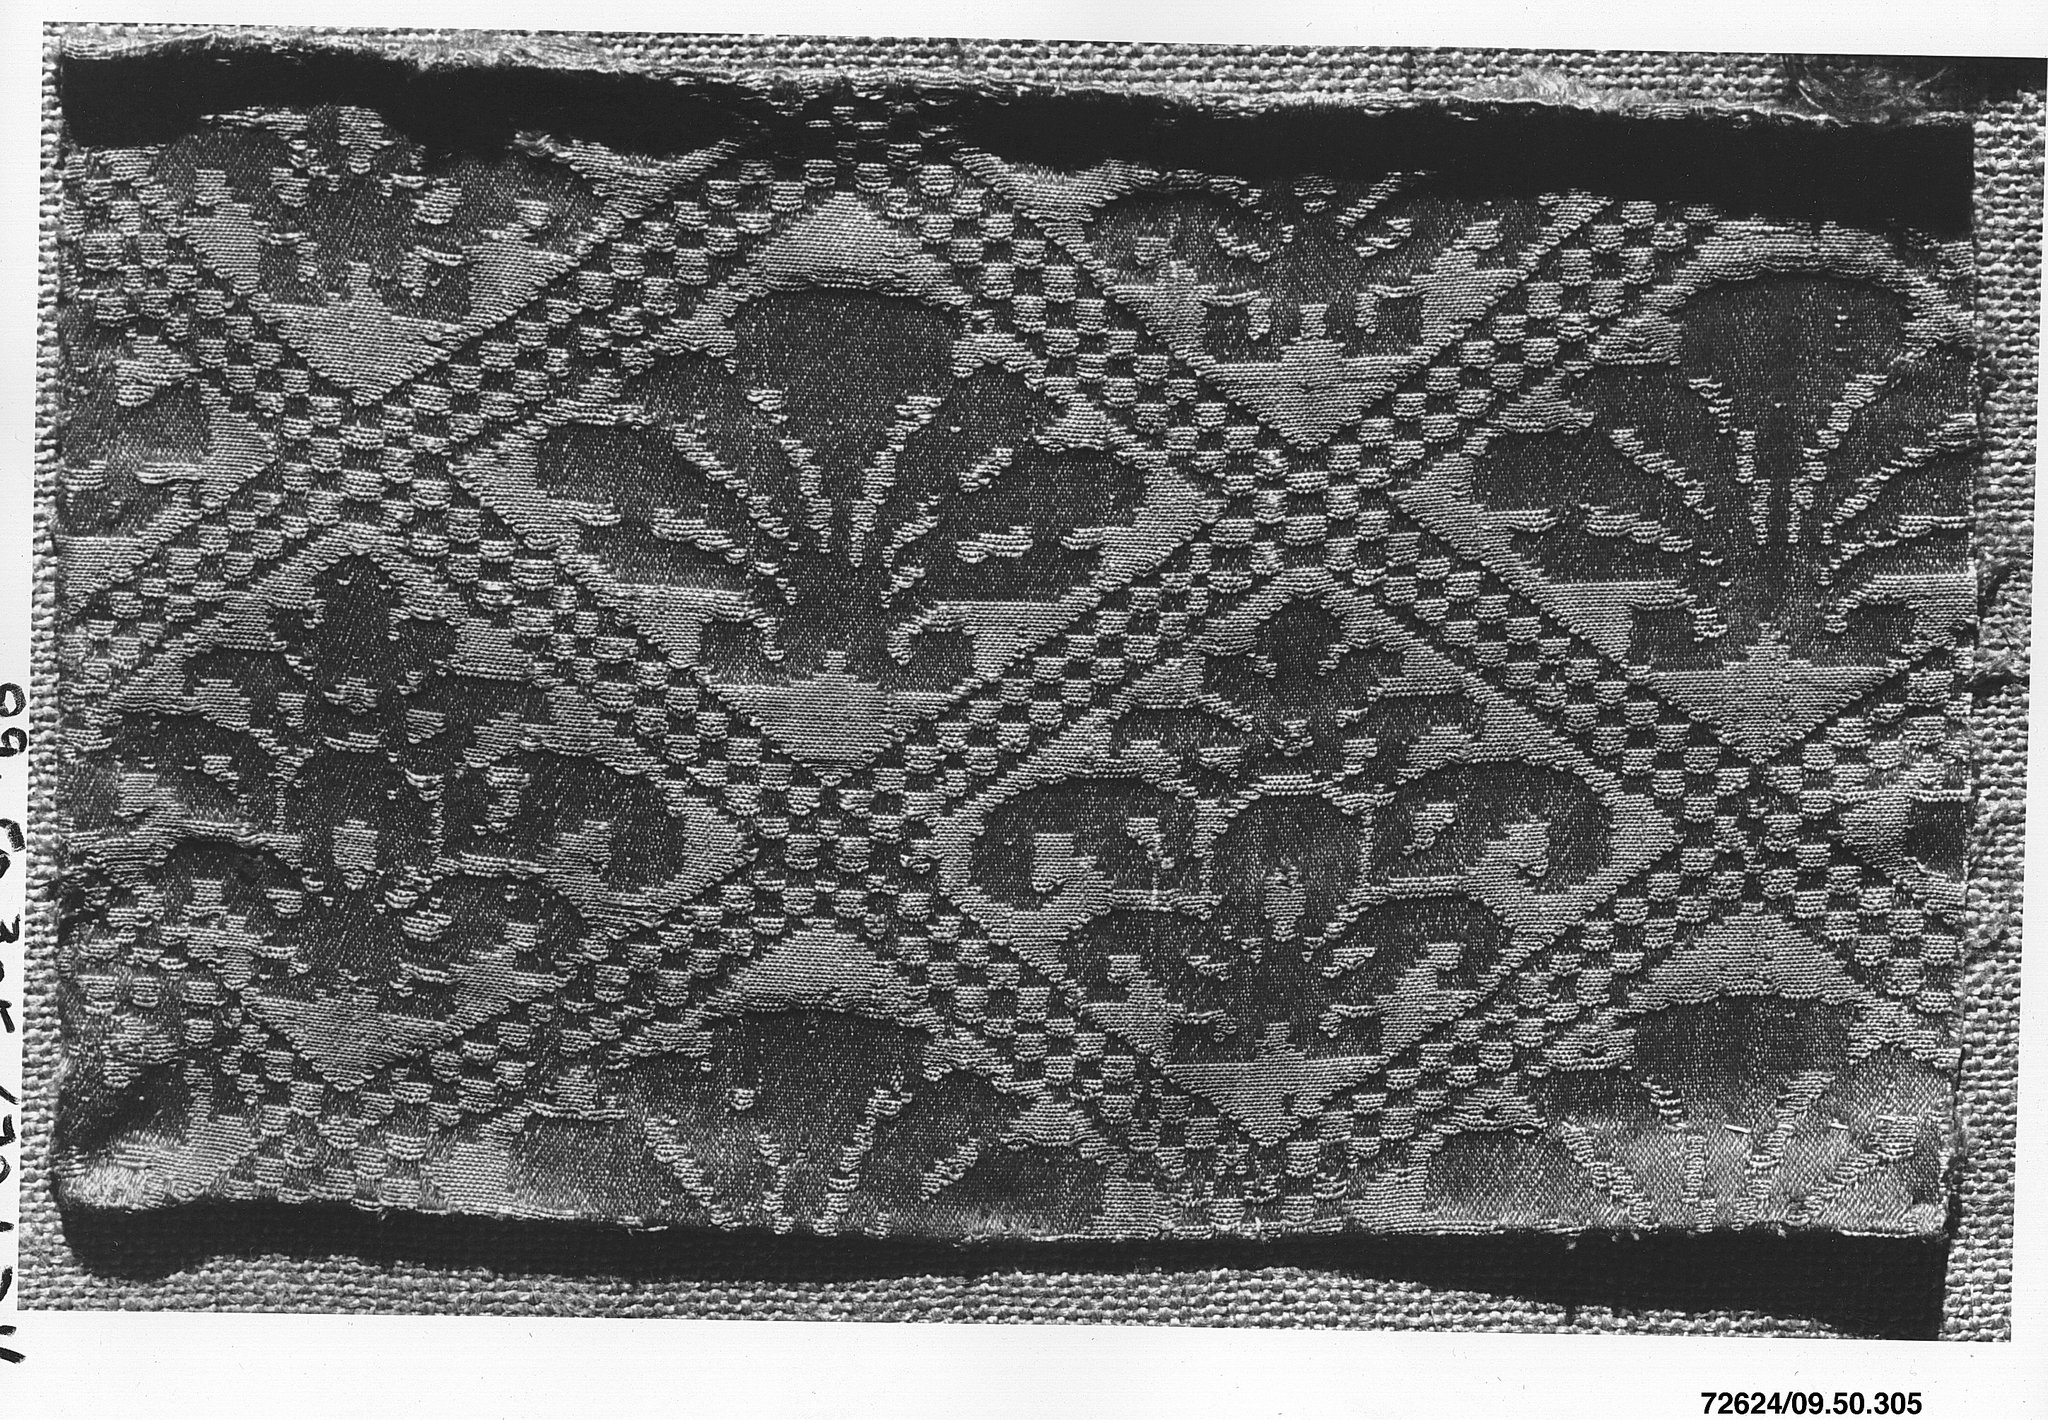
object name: piece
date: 1501-1700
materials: silk